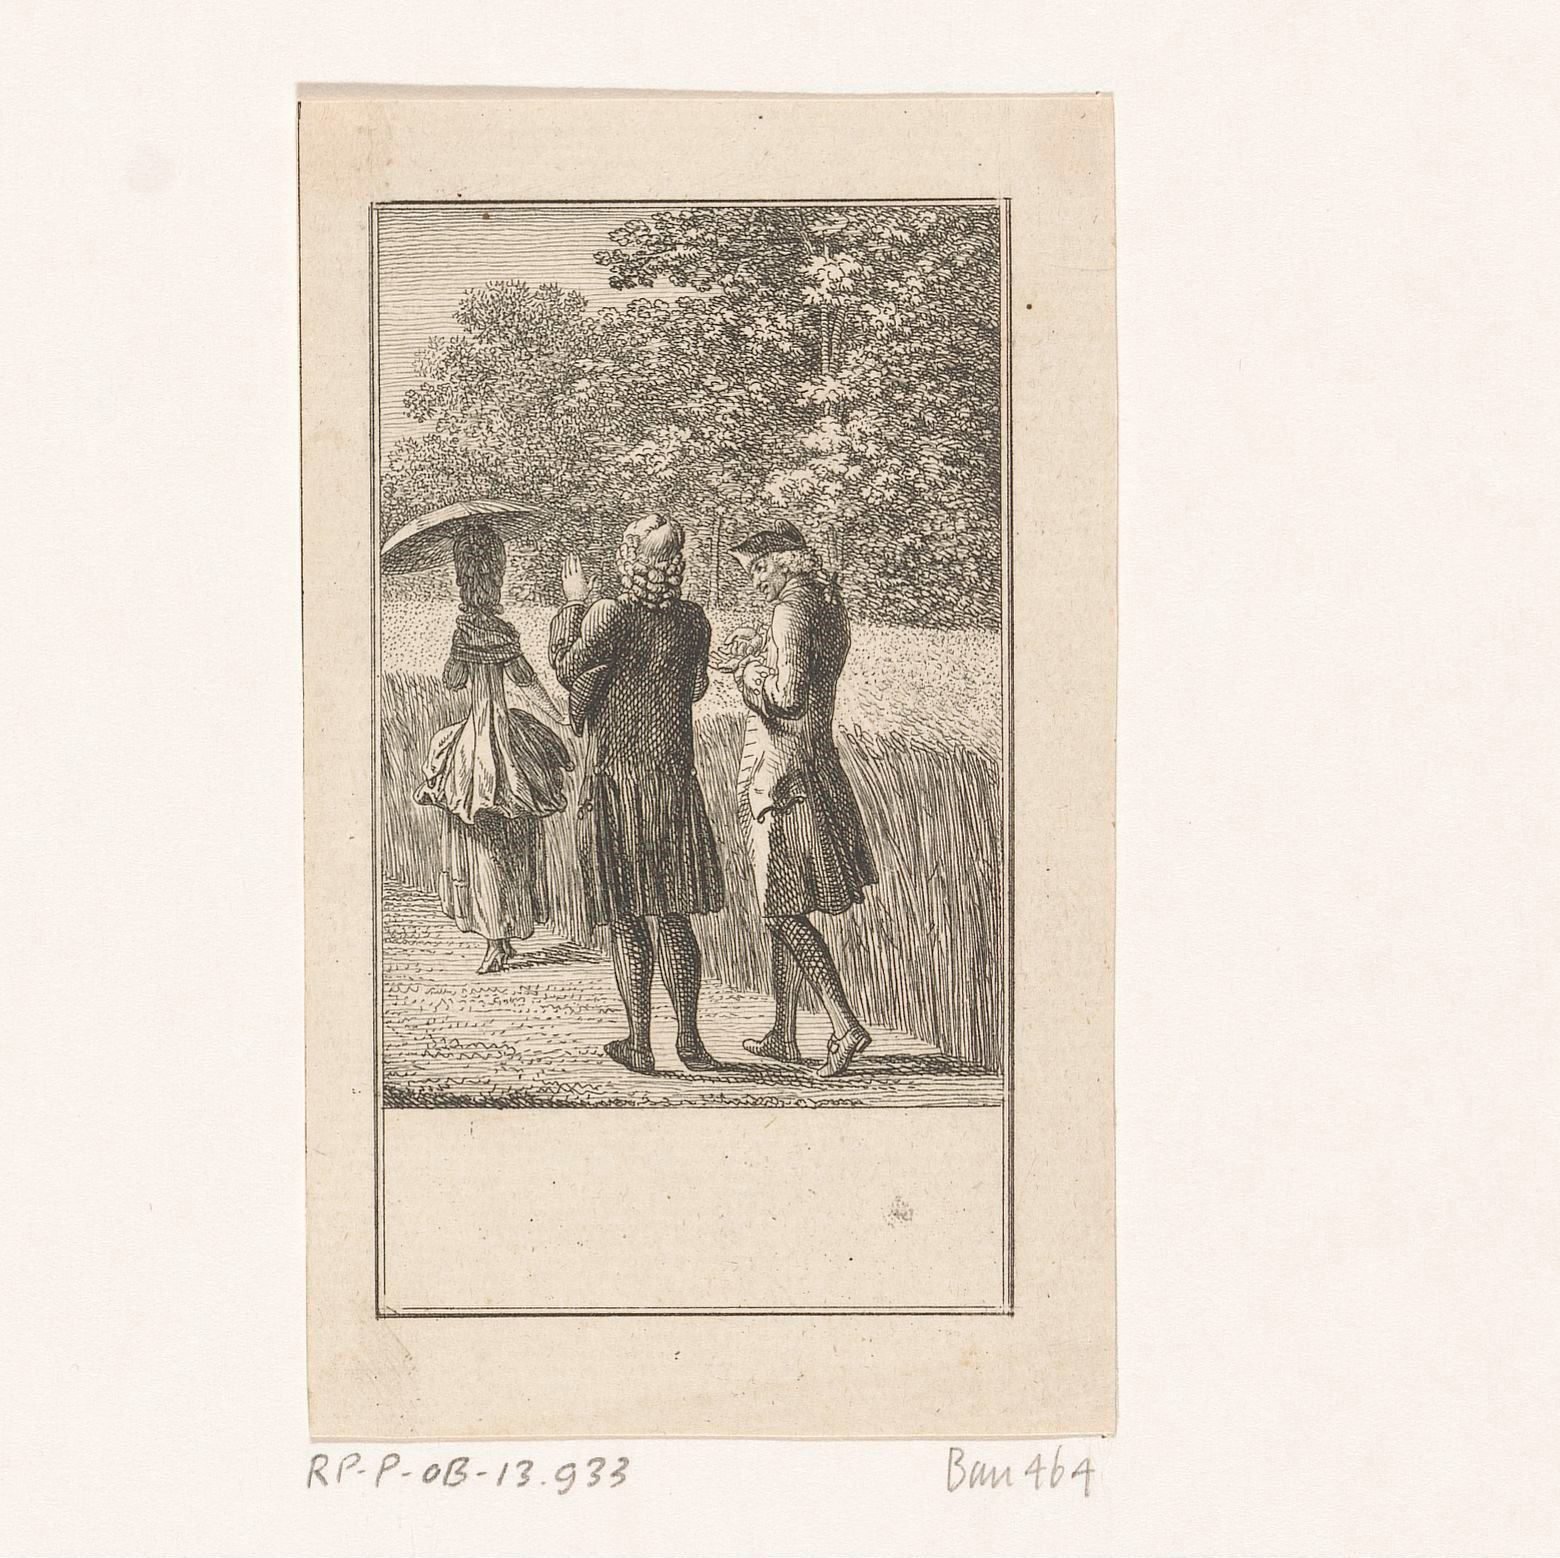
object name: print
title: Twee mannen lopen achter een vrouw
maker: daniel nikolaus chodowiecki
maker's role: draughtsman, print maker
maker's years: 1726-1801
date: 1778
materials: paper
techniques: etching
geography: berlin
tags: cereal, grain, corn (grass with grains, grown for food, e.g.: wheat, rice, rye, oats, maize, buckwheat, millet), parasol, sunshade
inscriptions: collector's mark: Lugt 2228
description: Achtste prent uit een serie van twaalf moralistische en satirische voorstellingen. De scènes werden op een plaat geëtst. Een latere staat van deze serie gebruikt in: Launburger genealogischen Kalender auf das Jahr 1779. Chodowiecki herhaalde deze serie nog tweemaal: eenmaal voor de Franse editie van deze almanak en nog eenmaal voor de Duitse editie.